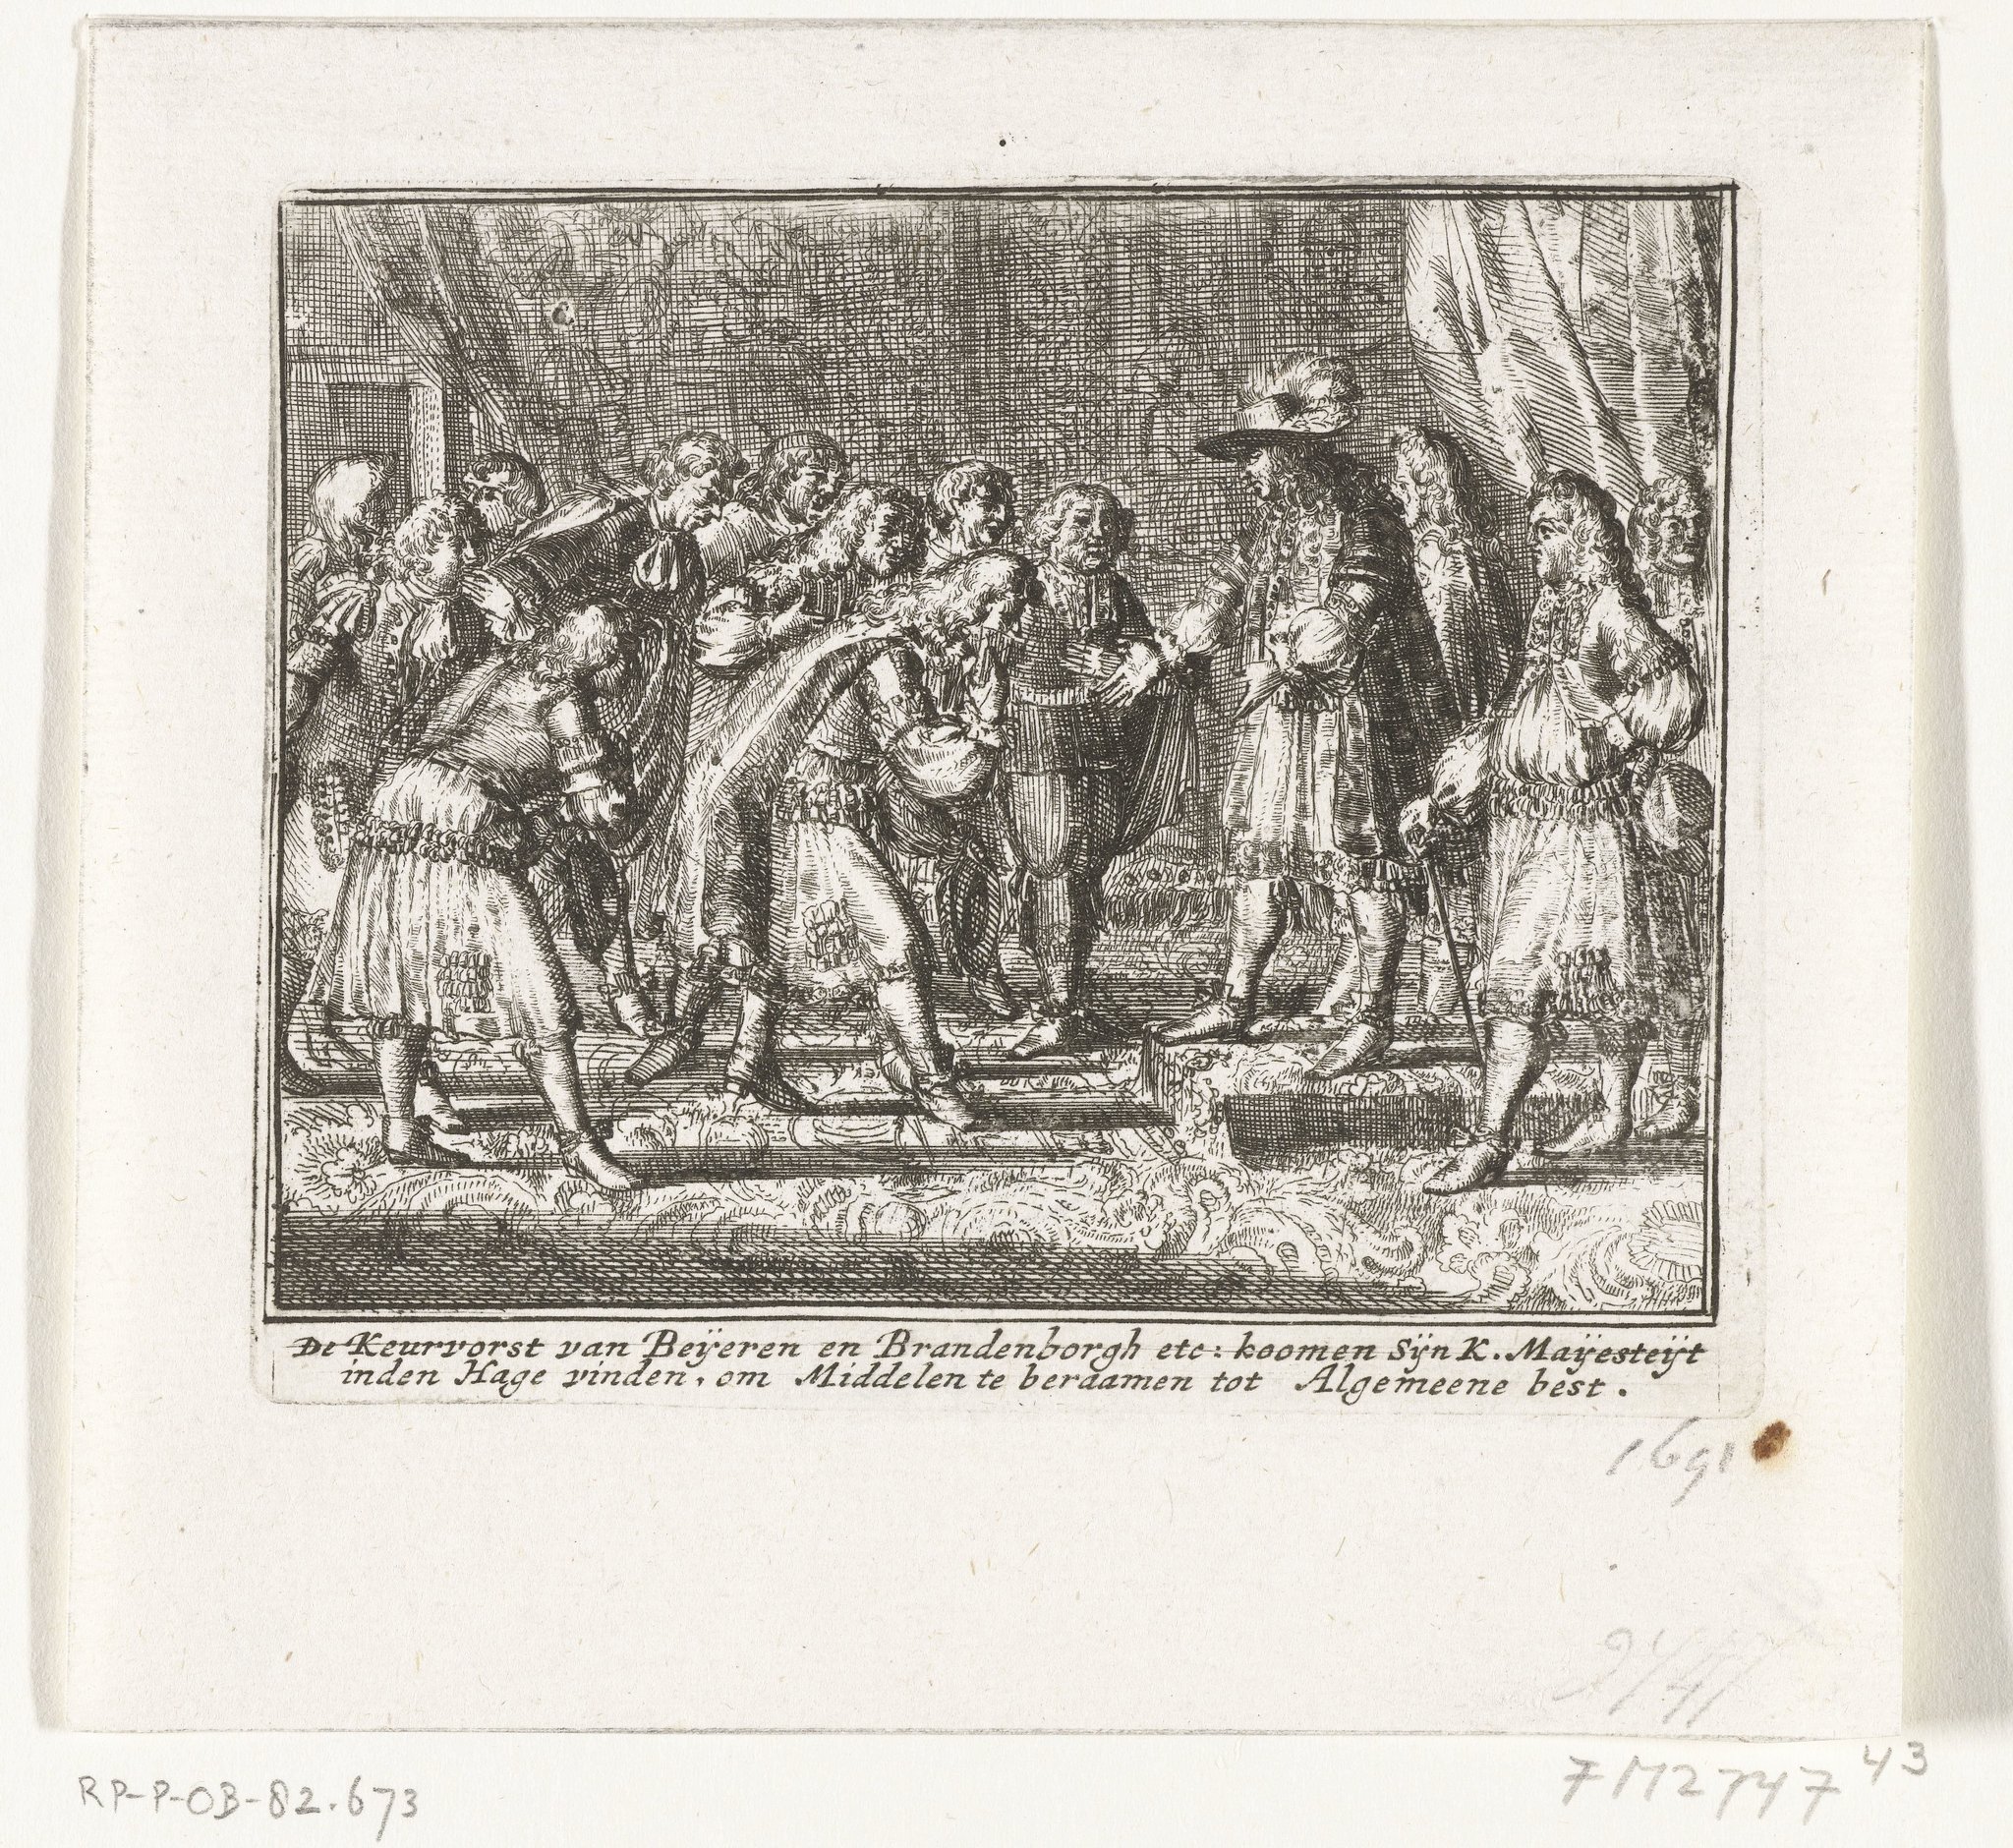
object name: print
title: De keurvorsten van Beieren en van Brandenburg op bezoek bij koning Willem III, 1691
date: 1711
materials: paper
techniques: etching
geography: northern netherlands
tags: william iii (prince of orange and king of england, scotland, and ireland), shaking hands, 'dextrarum junctio'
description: De keurvorsten van Beieren en van Brandenburg op bezoek bij koning Willem III, 1691. De vorsten begroeten elkaar en schudden elkaar de hand. Onderdeel van een serie over de lotgevallen van het Engelse koningshuis van Stuart van 1558-1711, waarvan hier zijn opgenomen zestien prenten over de strijd tussen Jacobus II en Willem III in de jaren 1688-1689.